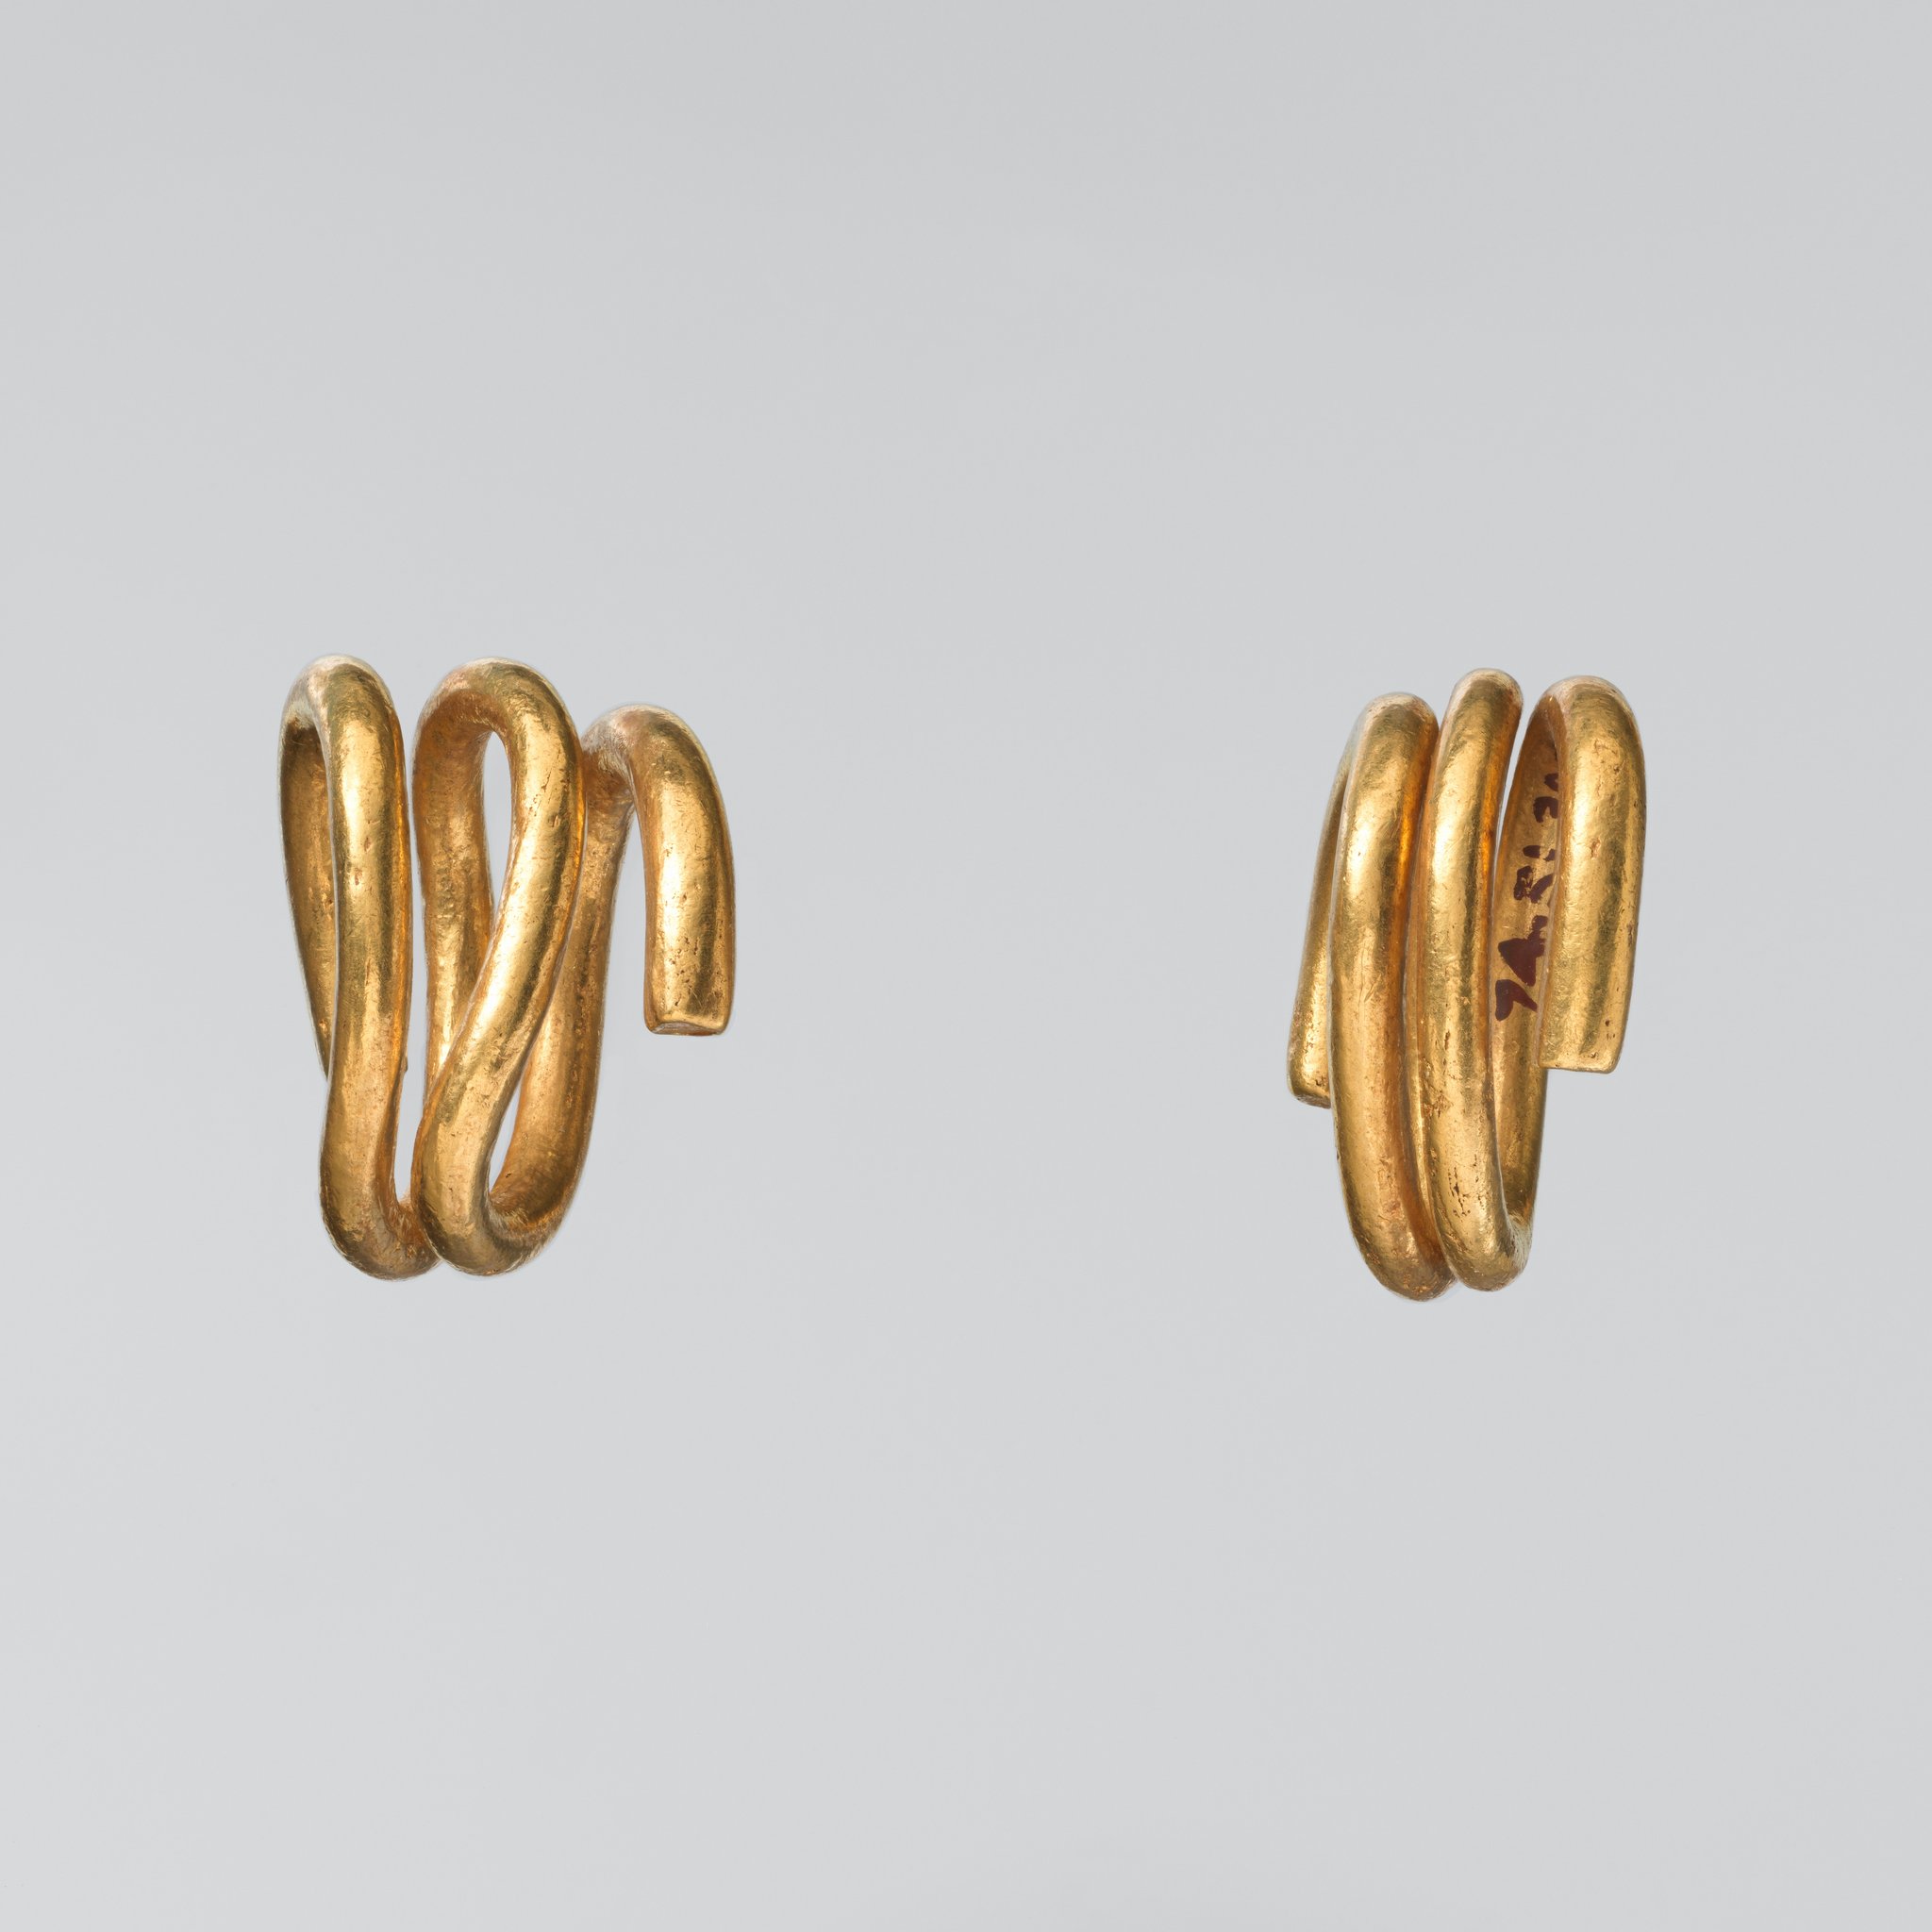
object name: earring or spiral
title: Gold spiral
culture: cypriot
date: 1600-1100 BCE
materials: gold